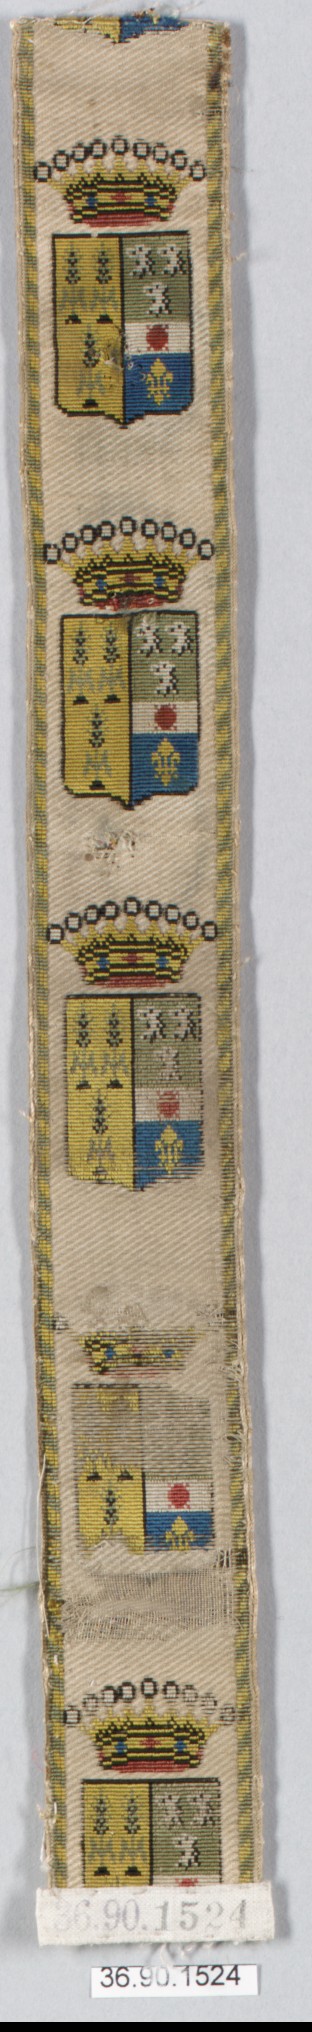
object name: galloon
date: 1701-1900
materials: silk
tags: coat of arms